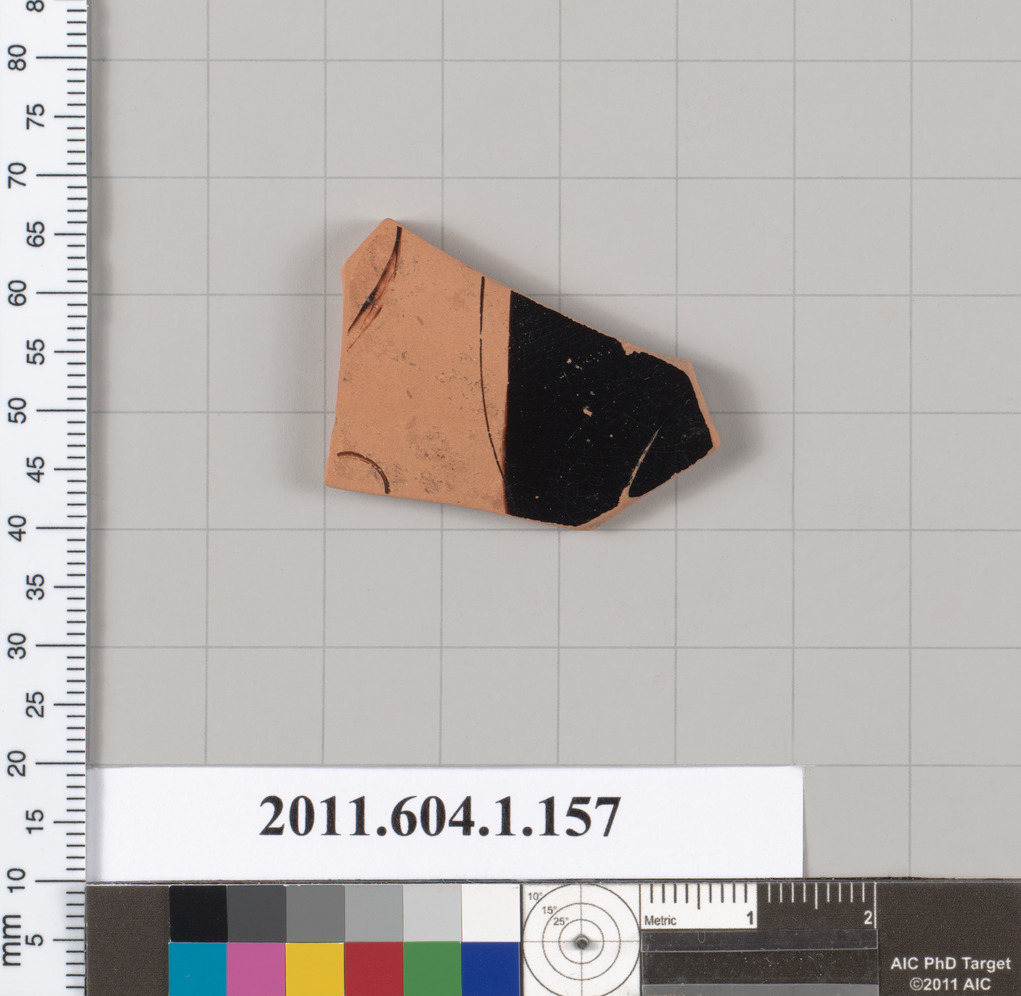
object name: kylix fragment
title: Terracotta fragment of a kylix (drinking cup)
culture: greek, attic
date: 475-451 BCE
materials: terracotta